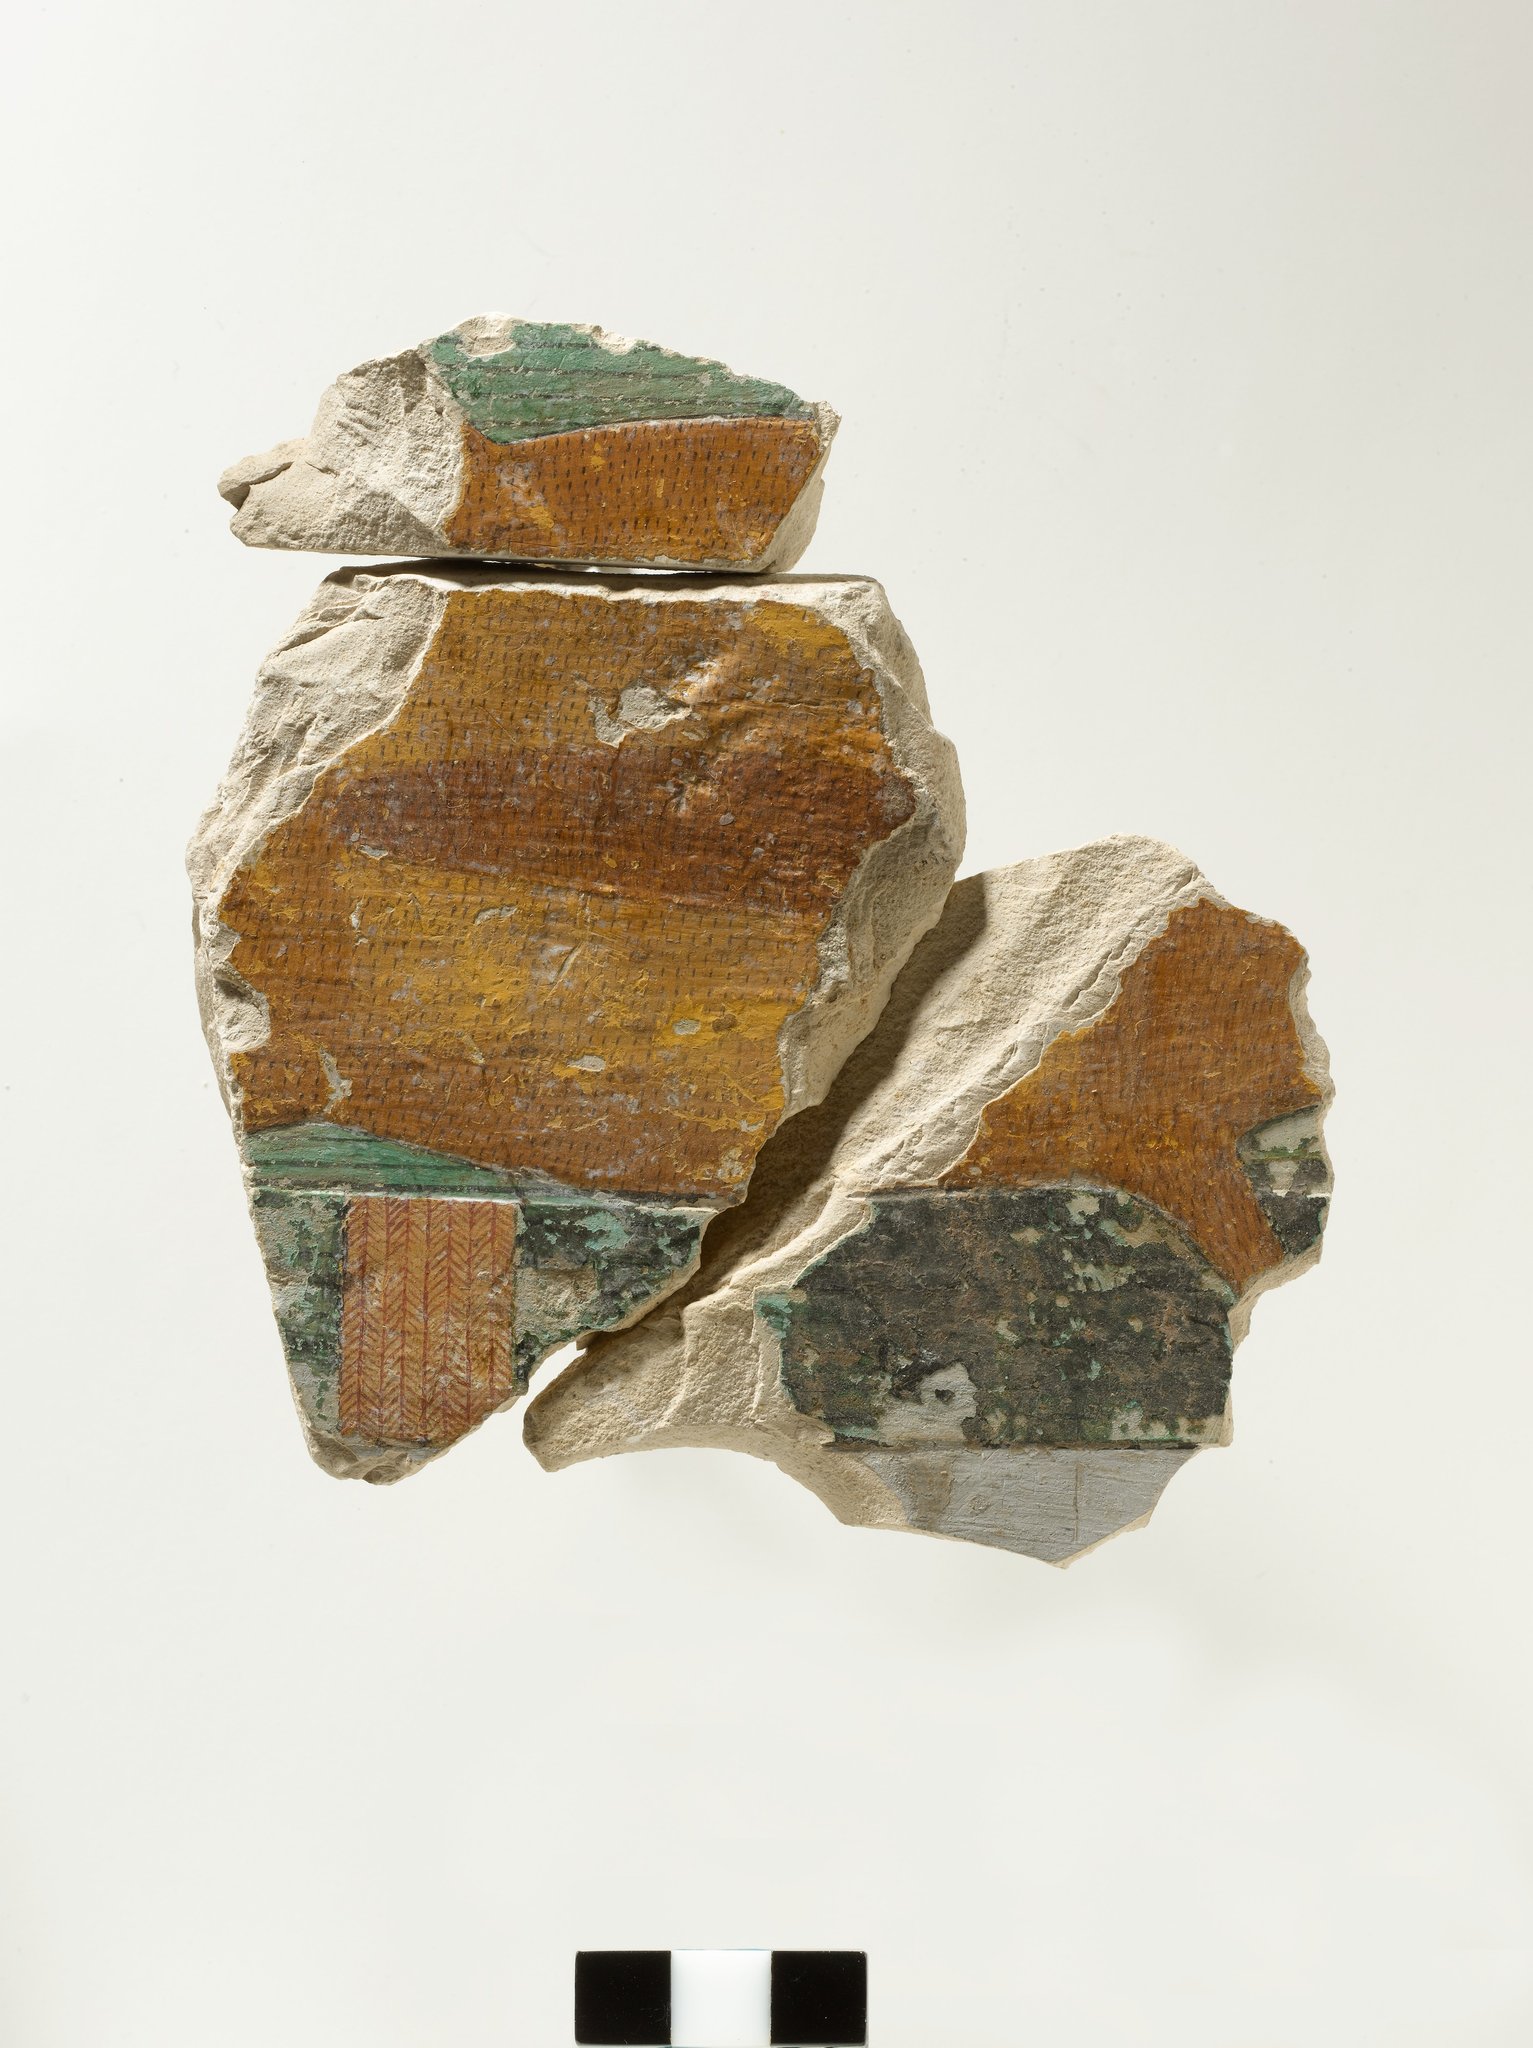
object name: relief fragment, tomb of meketre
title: Relief fragment from the tomb of Meketre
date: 1981-1975 BCE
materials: limestone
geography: egypt